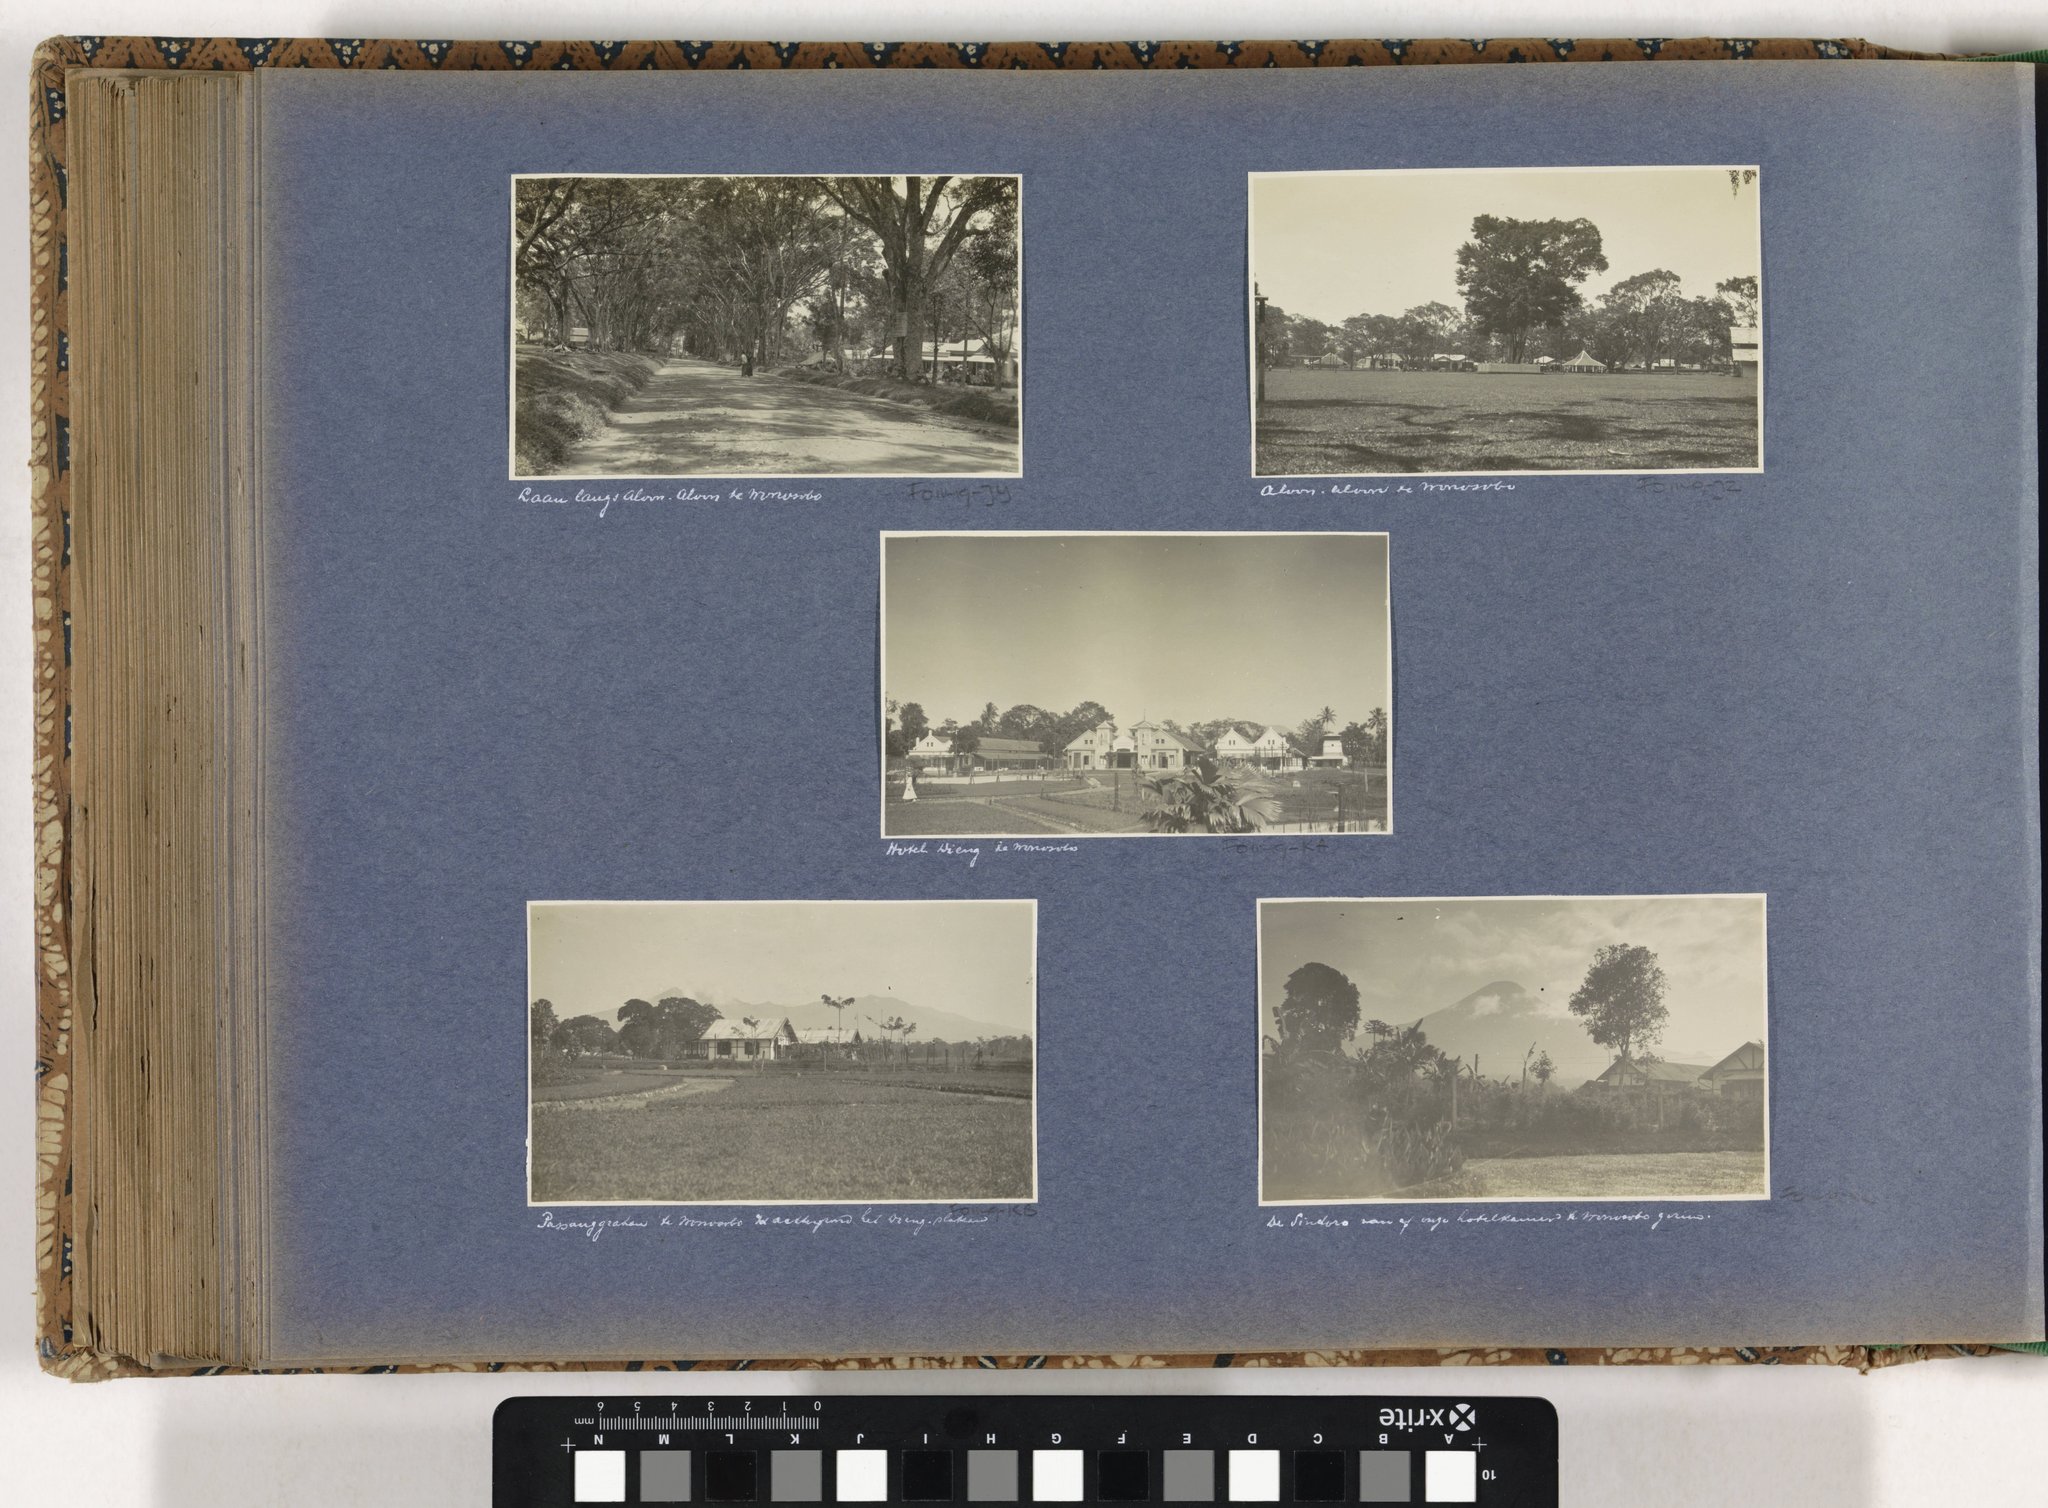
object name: photograph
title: Vulkaan Sindoro op Java gezien vanuit een hotelkamer in Wonosobo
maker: Anonymous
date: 1900-1920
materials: paper, photographic support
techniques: gelatin silver print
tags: volcano, hotel, hostelry, inn, java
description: Onderdeel van reisalbum met foto's van bedrijvigheid en bezienswaardigheden op Sumatra en Java en van de reis naar en van Nederlands-Indië.